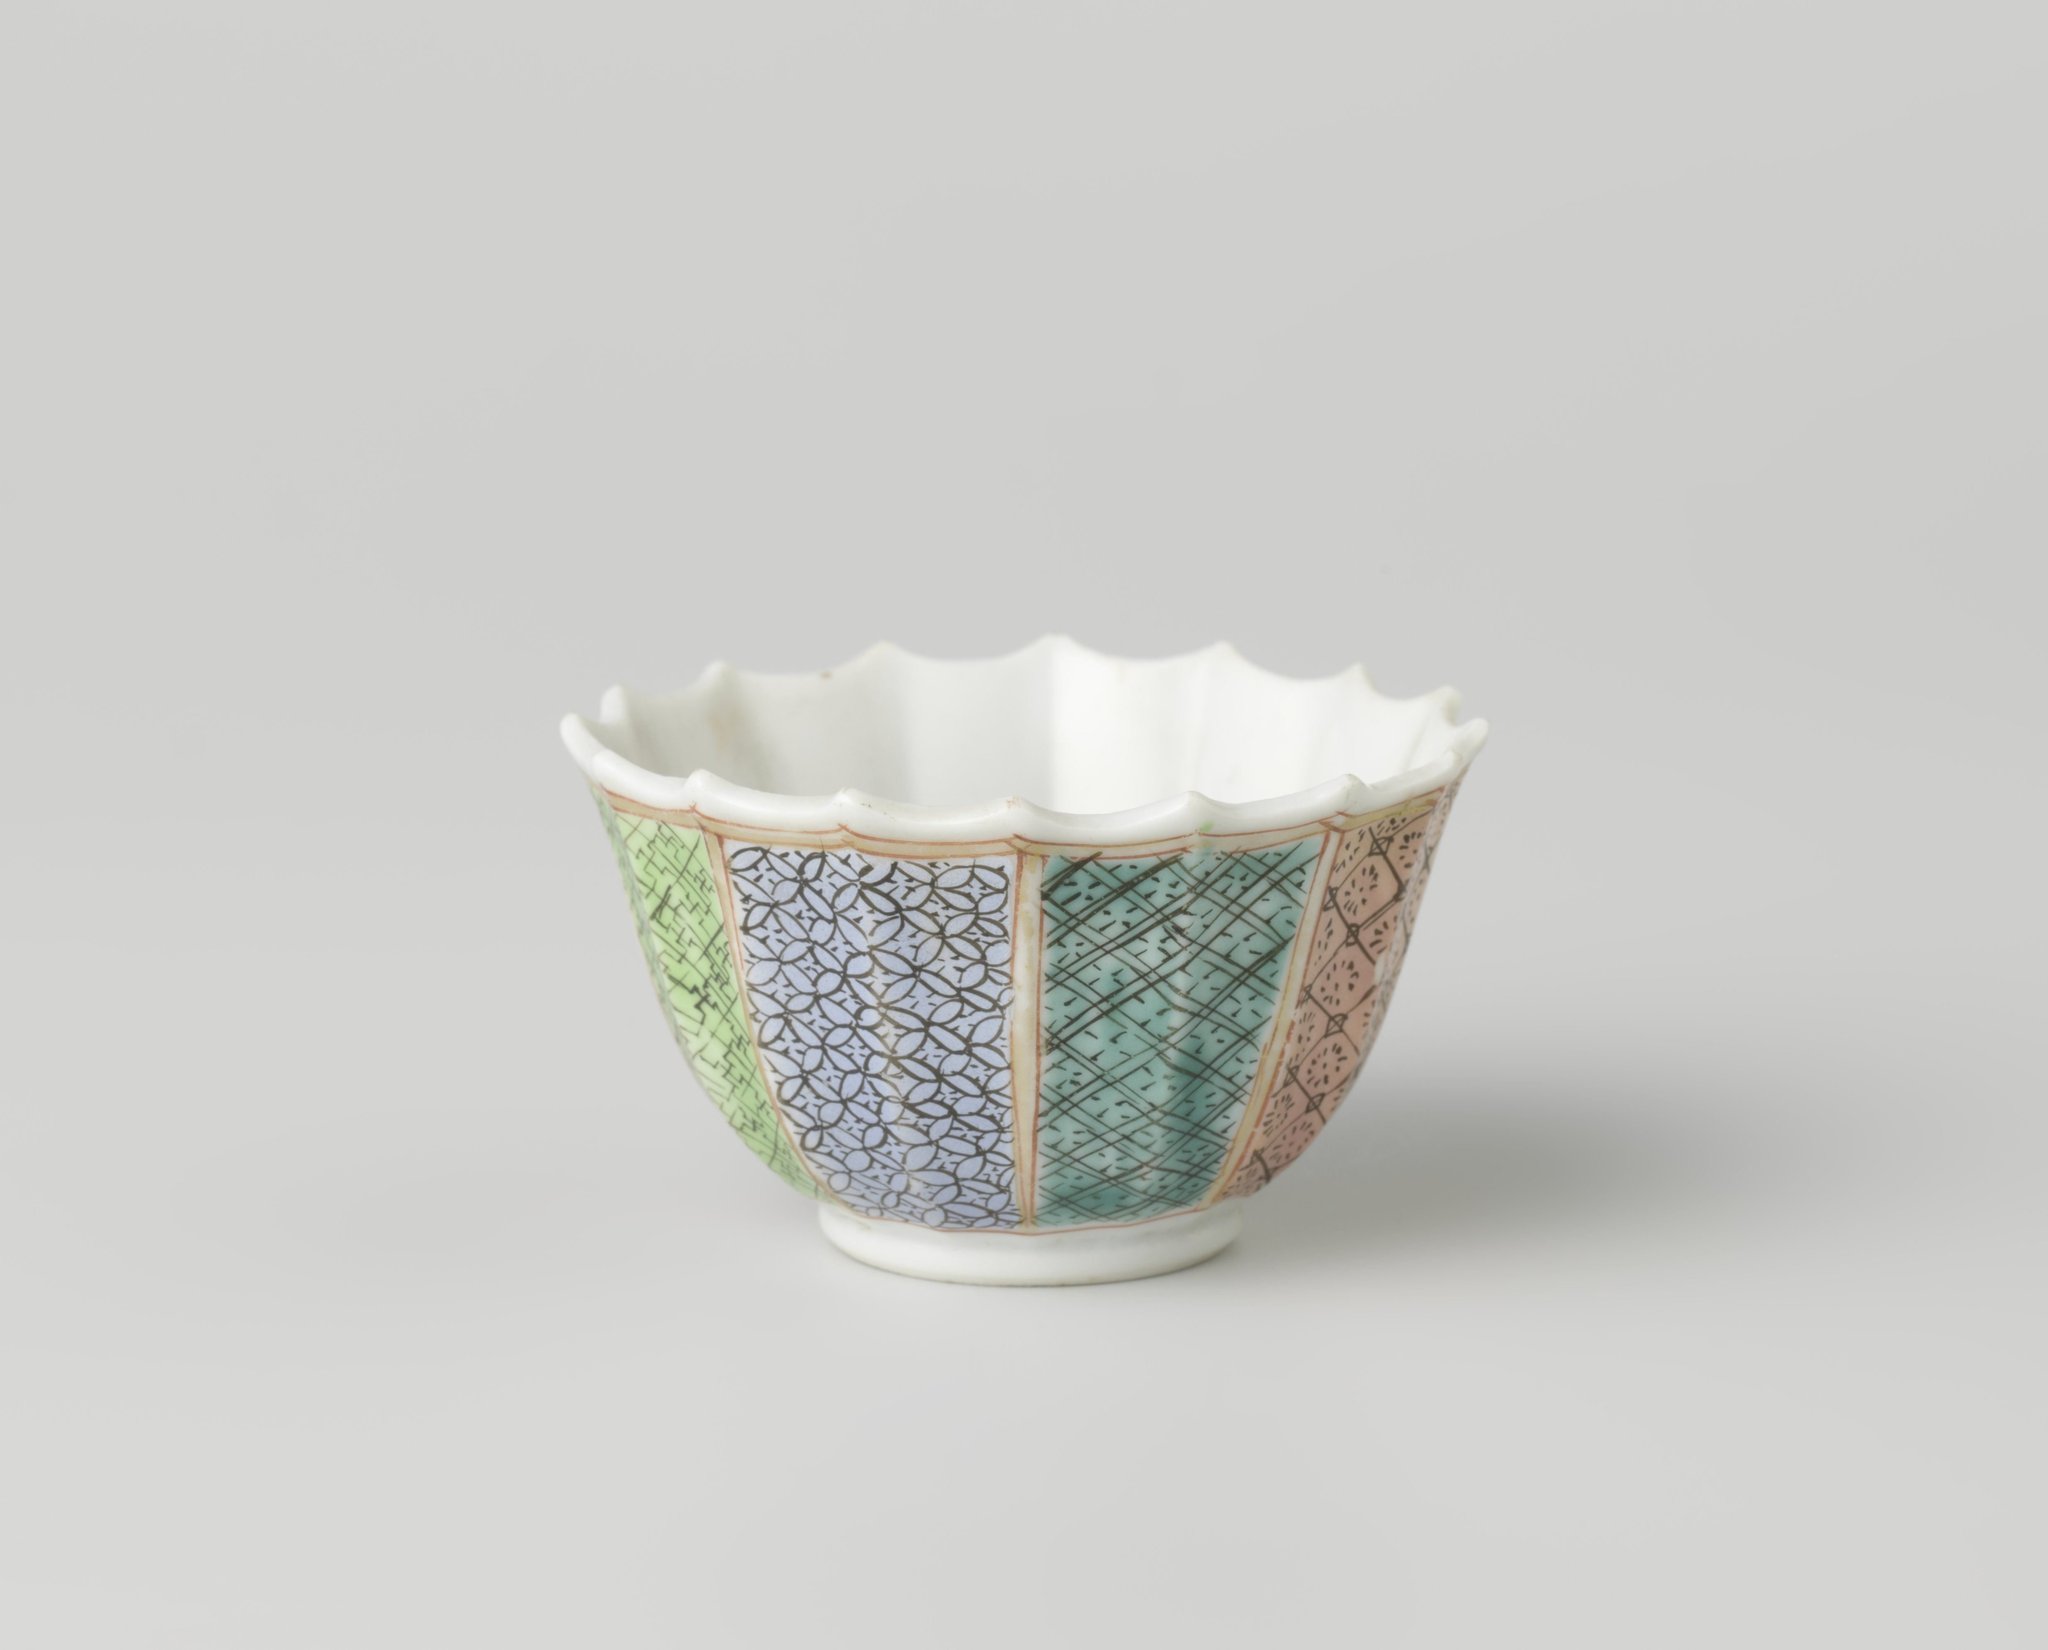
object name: kop en schotel, kop en schotel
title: Bell-shaped cup with a putto holding a lotusbranch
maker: Anonymous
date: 1725-1749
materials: glaze, gold, paint, porcelain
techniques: firing, forming, gilding, turning, vitrification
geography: china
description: Kop en schotel, met gegolfde rand met verschillende kleuren in midden een amaret met bloemtak.